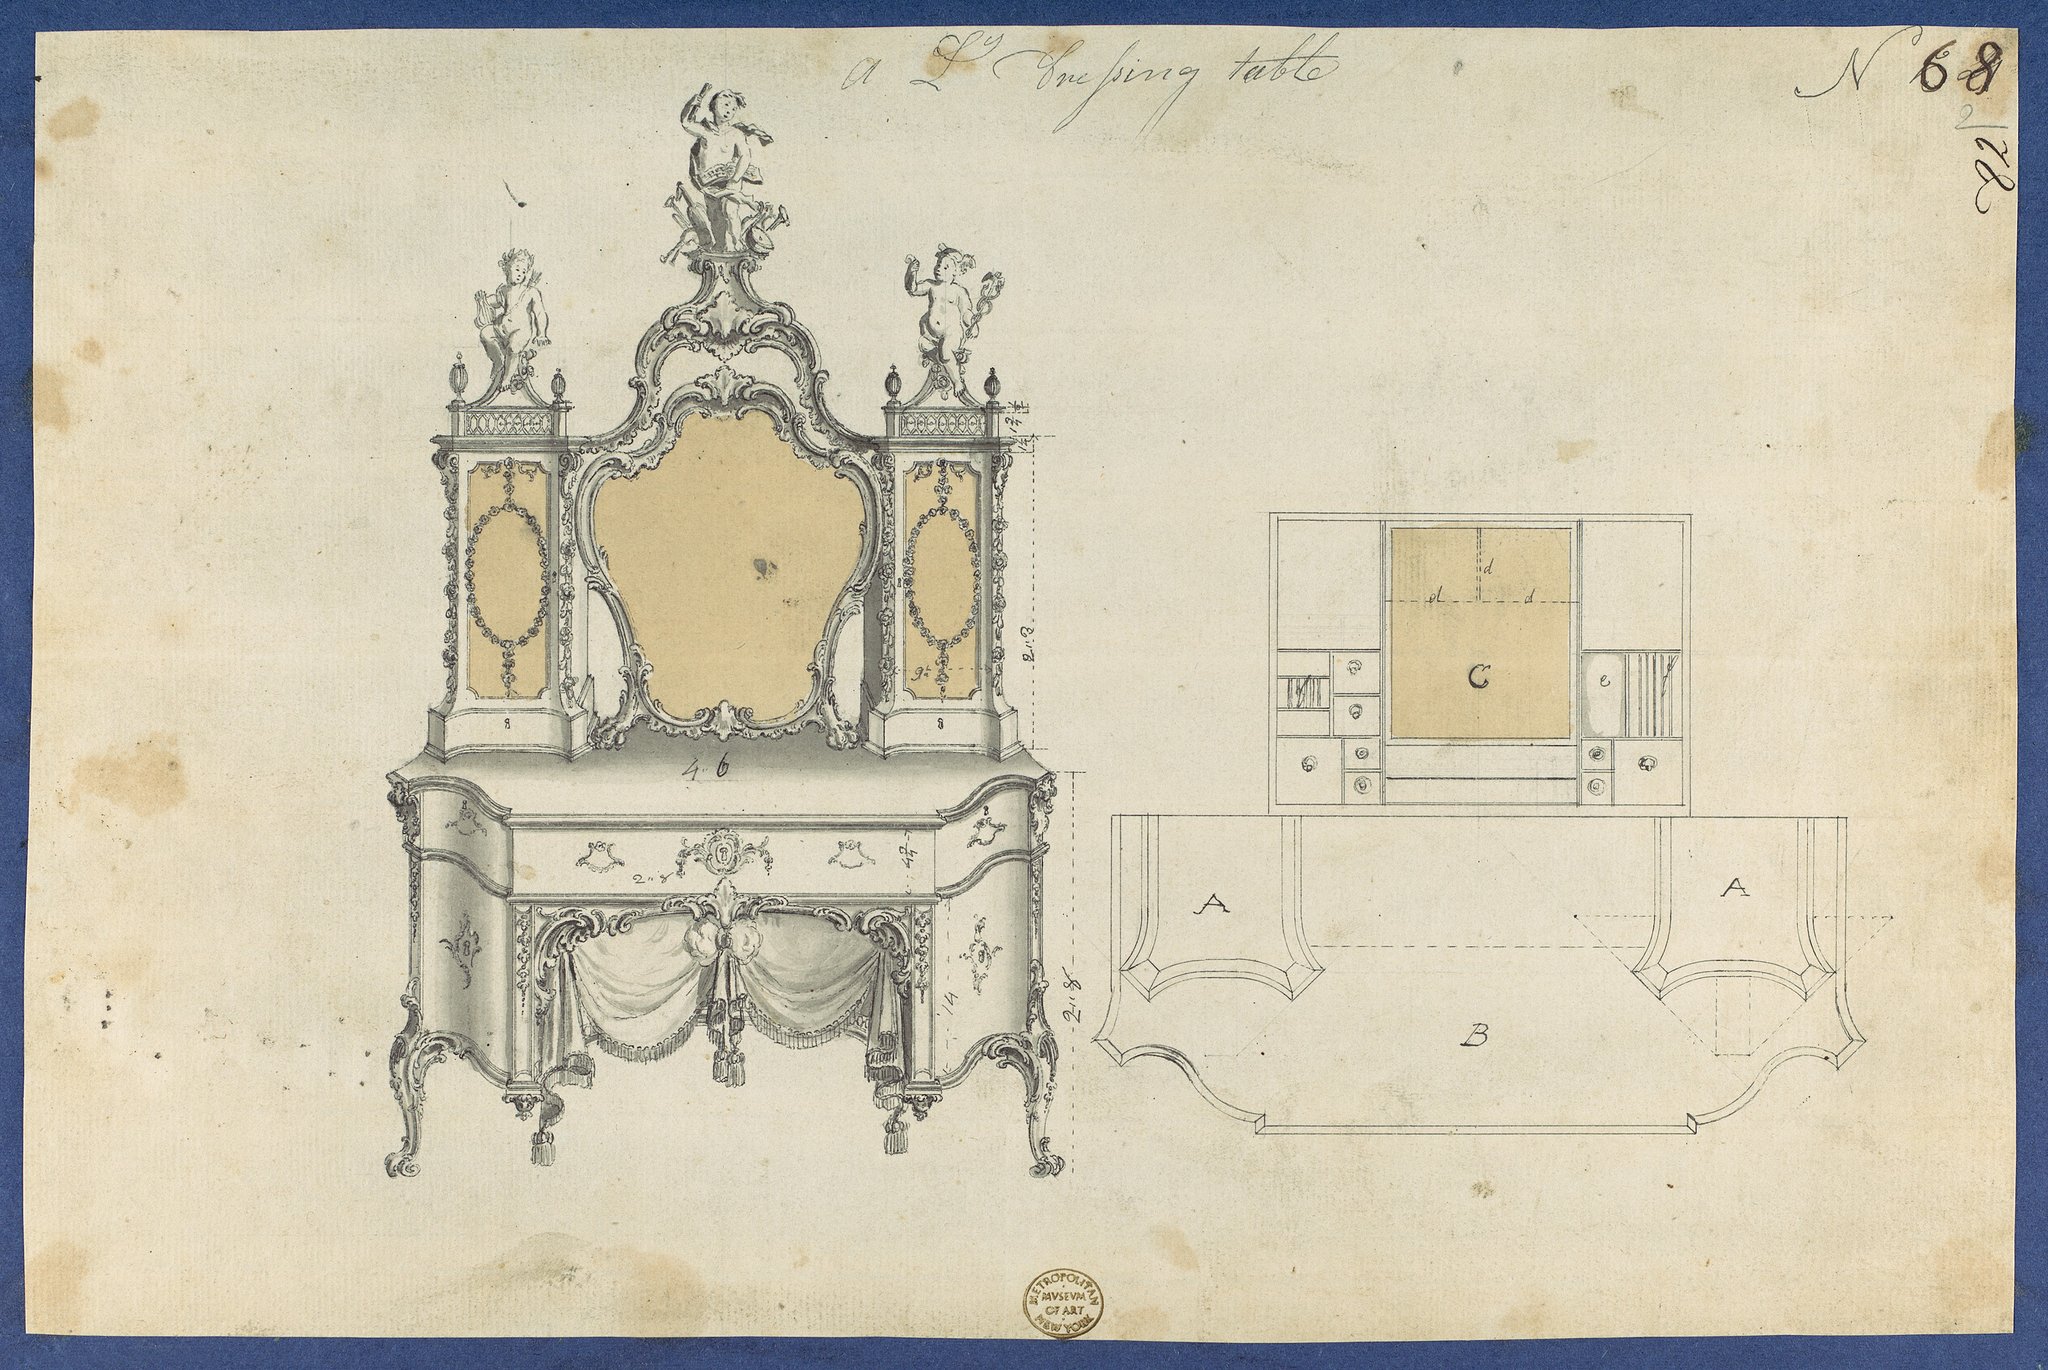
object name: drawing ornament architecture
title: A Lady's Dressing Table, from Chippendale Drawings, Vol. II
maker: thomas chippendale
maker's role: artist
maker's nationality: british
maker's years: 1718-1779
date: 1761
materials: ink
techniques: wash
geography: london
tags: tables